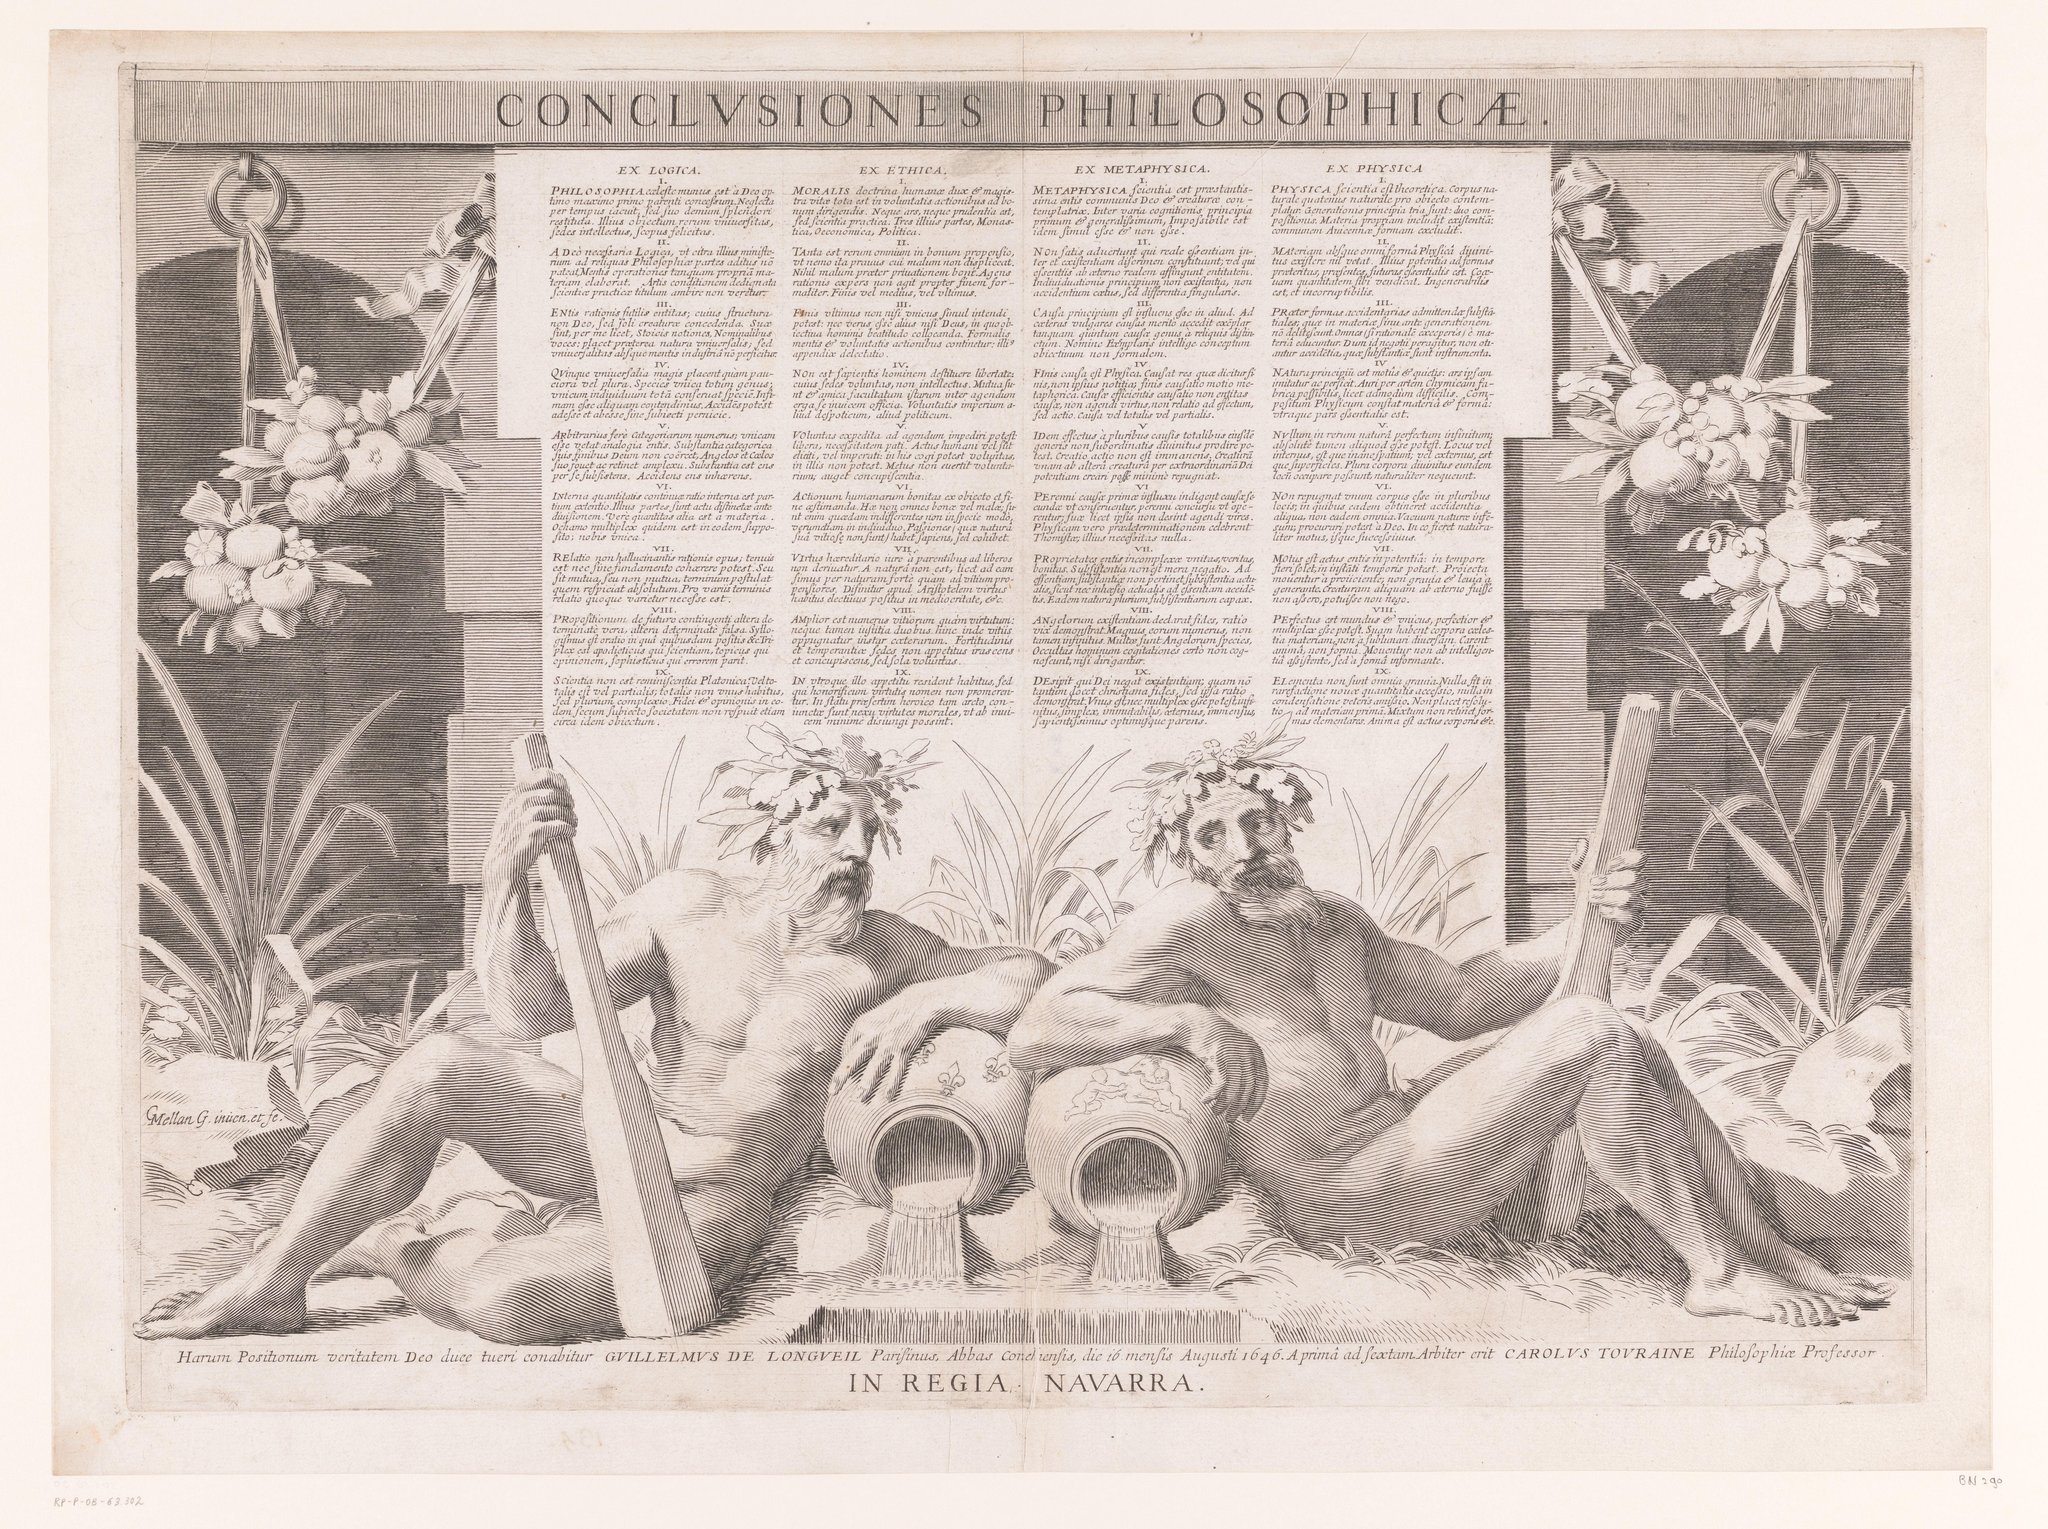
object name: print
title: These der filosofie van Guillaume de Longueil (onderste gedeelte)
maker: claude mellan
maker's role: draughtsman, print maker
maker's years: 1598-1688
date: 1646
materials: paper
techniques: engraving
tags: river-gods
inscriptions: collector's mark: Lugt 240, watermark